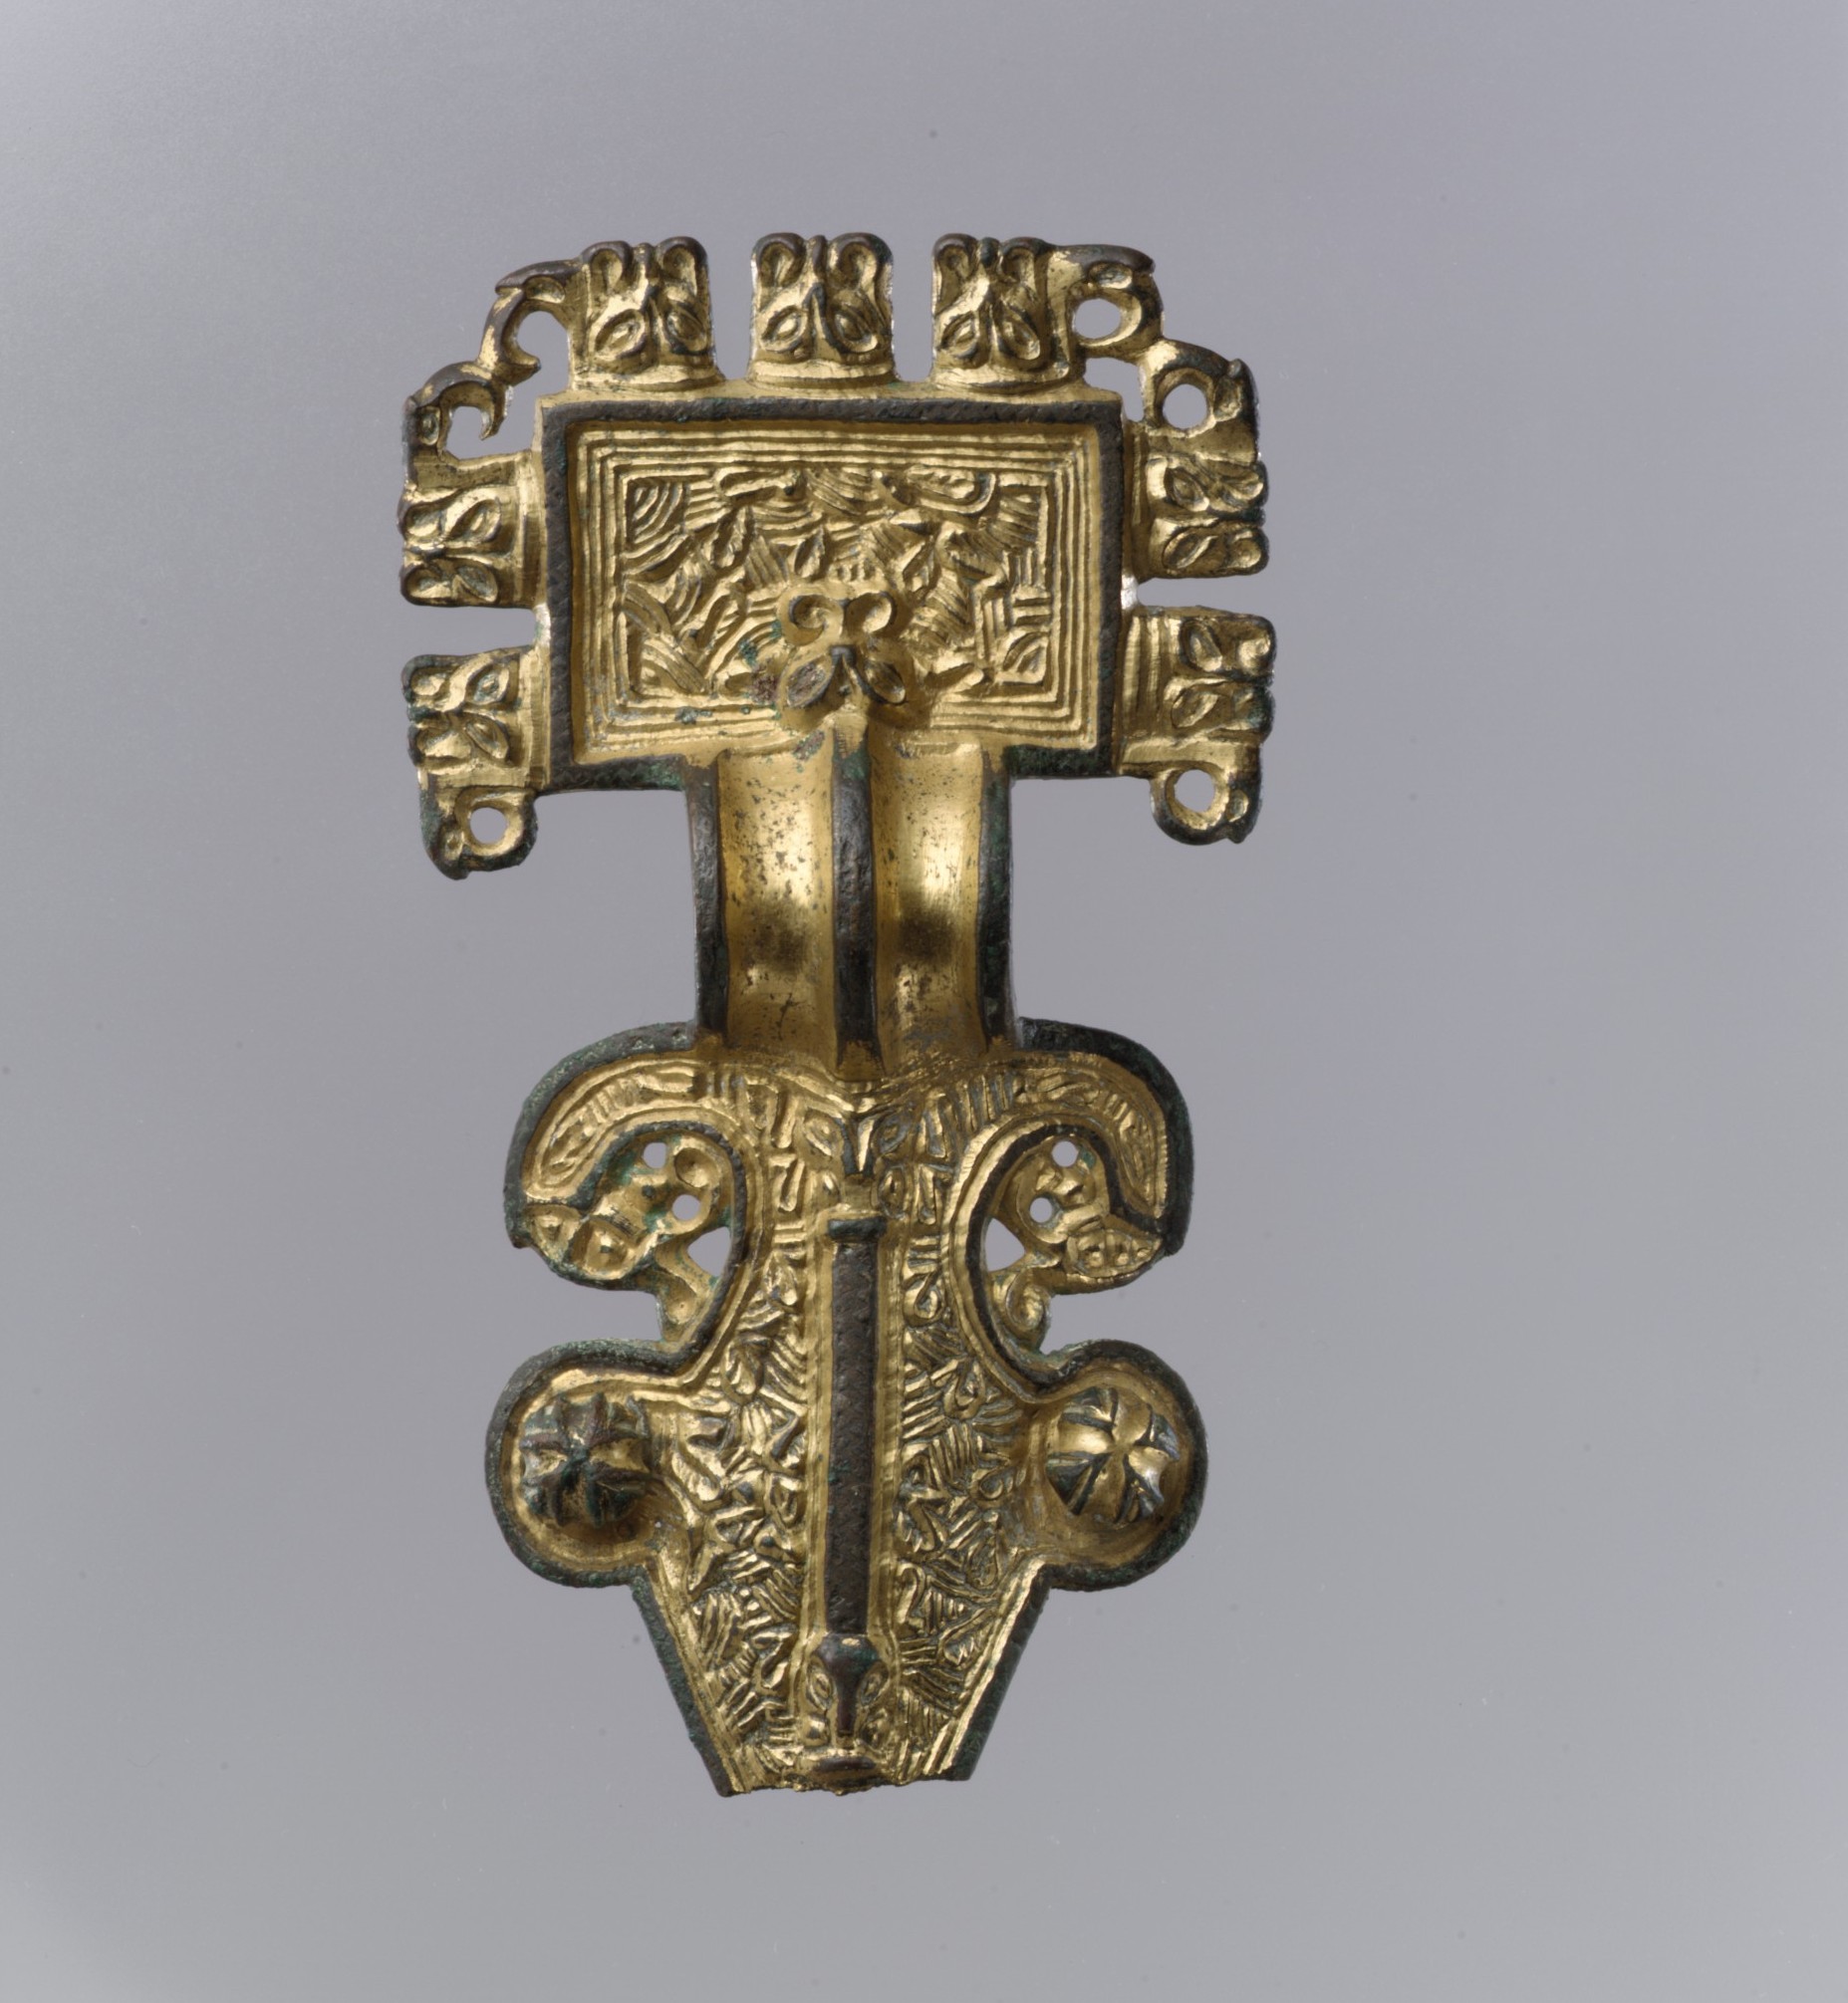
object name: brooch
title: Square-Headed Bow Brooch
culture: anglo-saxon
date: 500-600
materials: alloy, gilt copper, niello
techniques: inlay